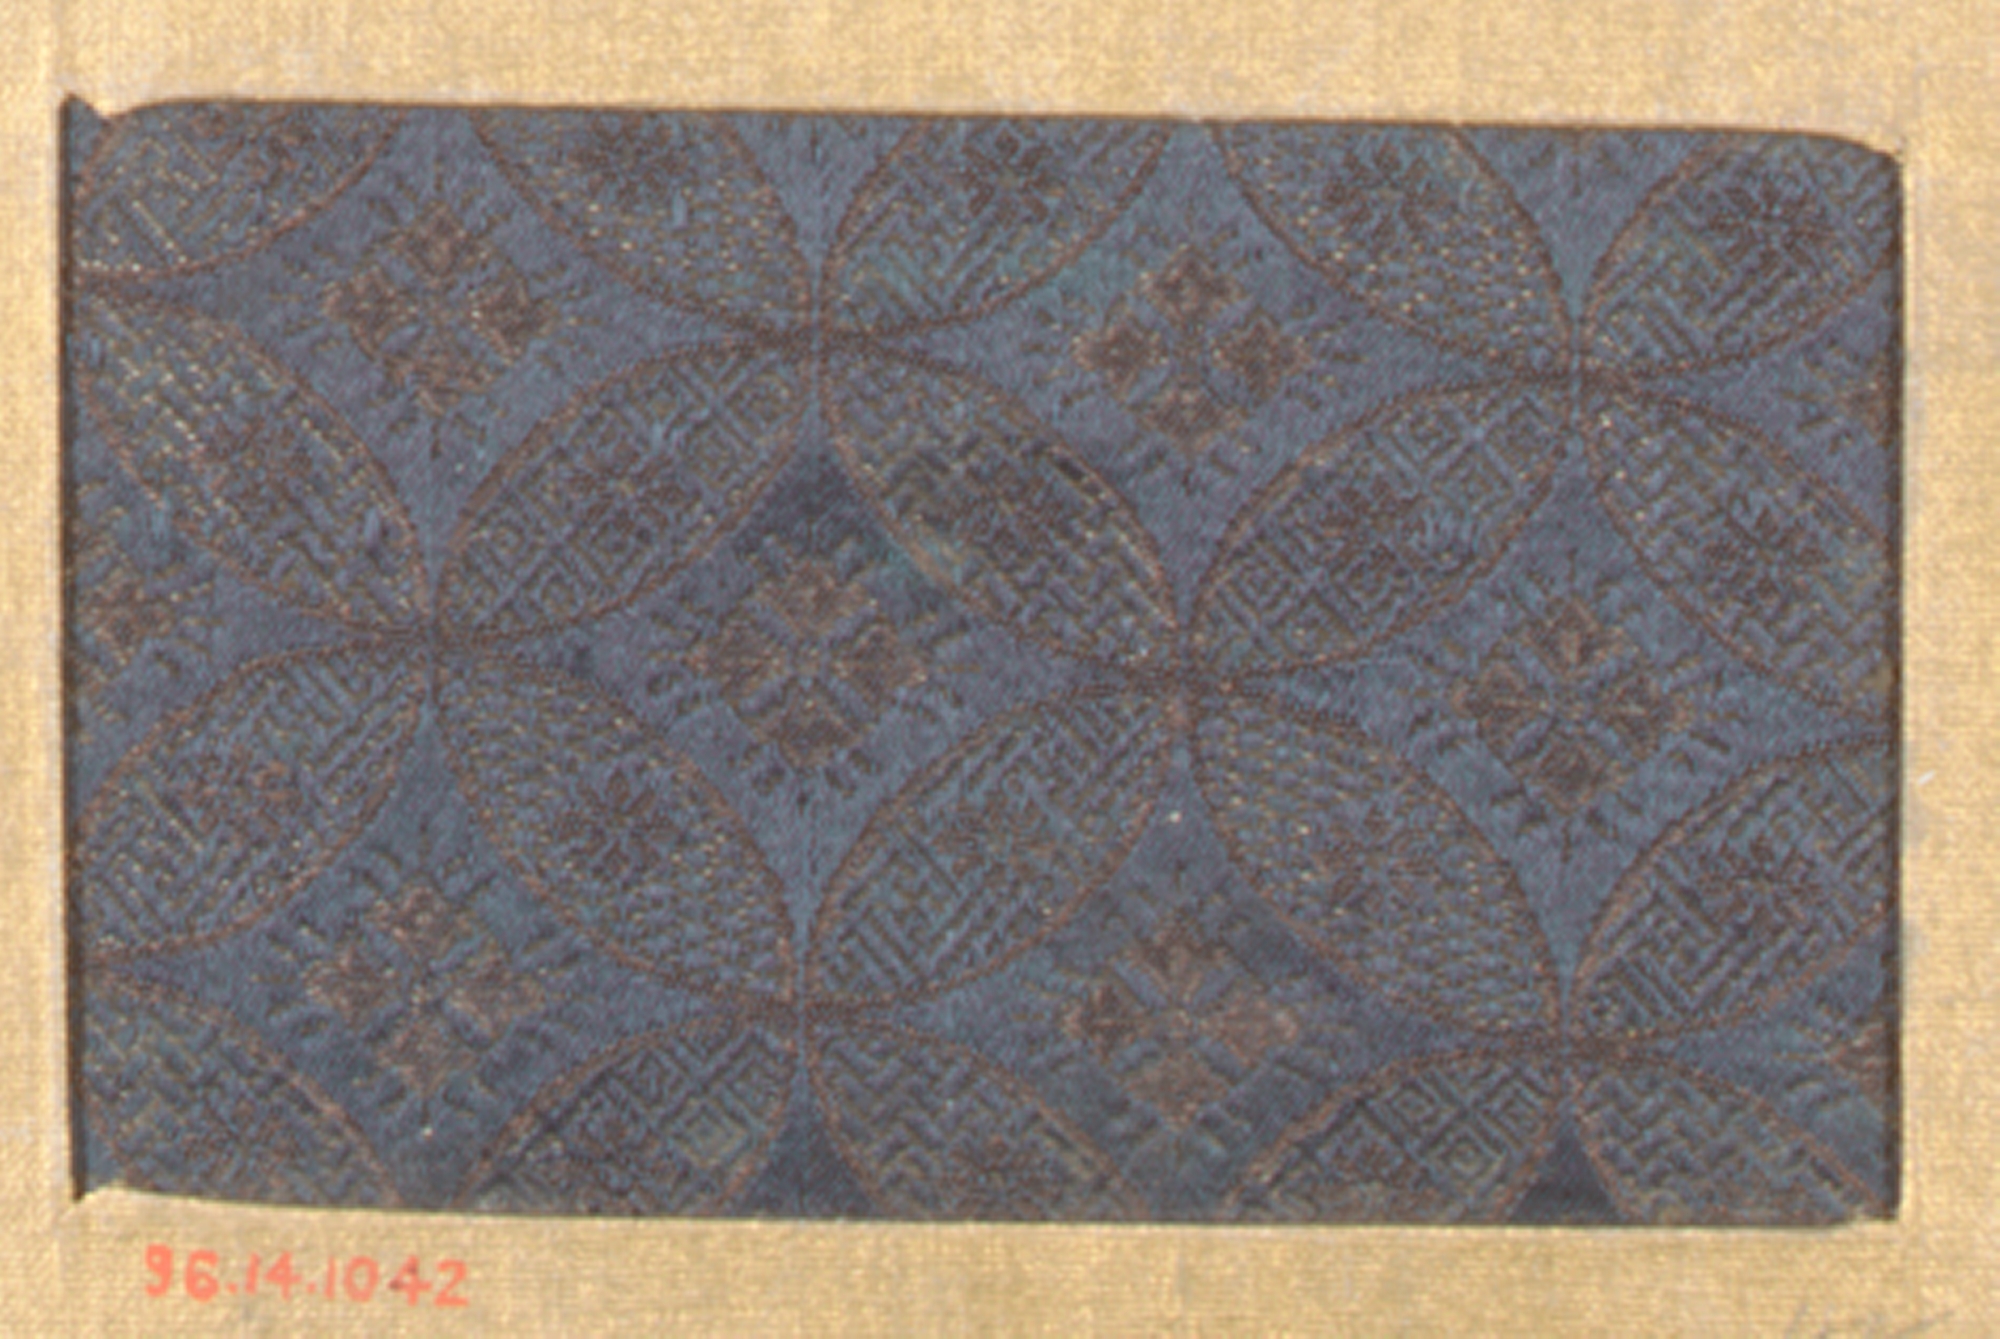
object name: piece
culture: japanese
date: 1701-1900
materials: silk